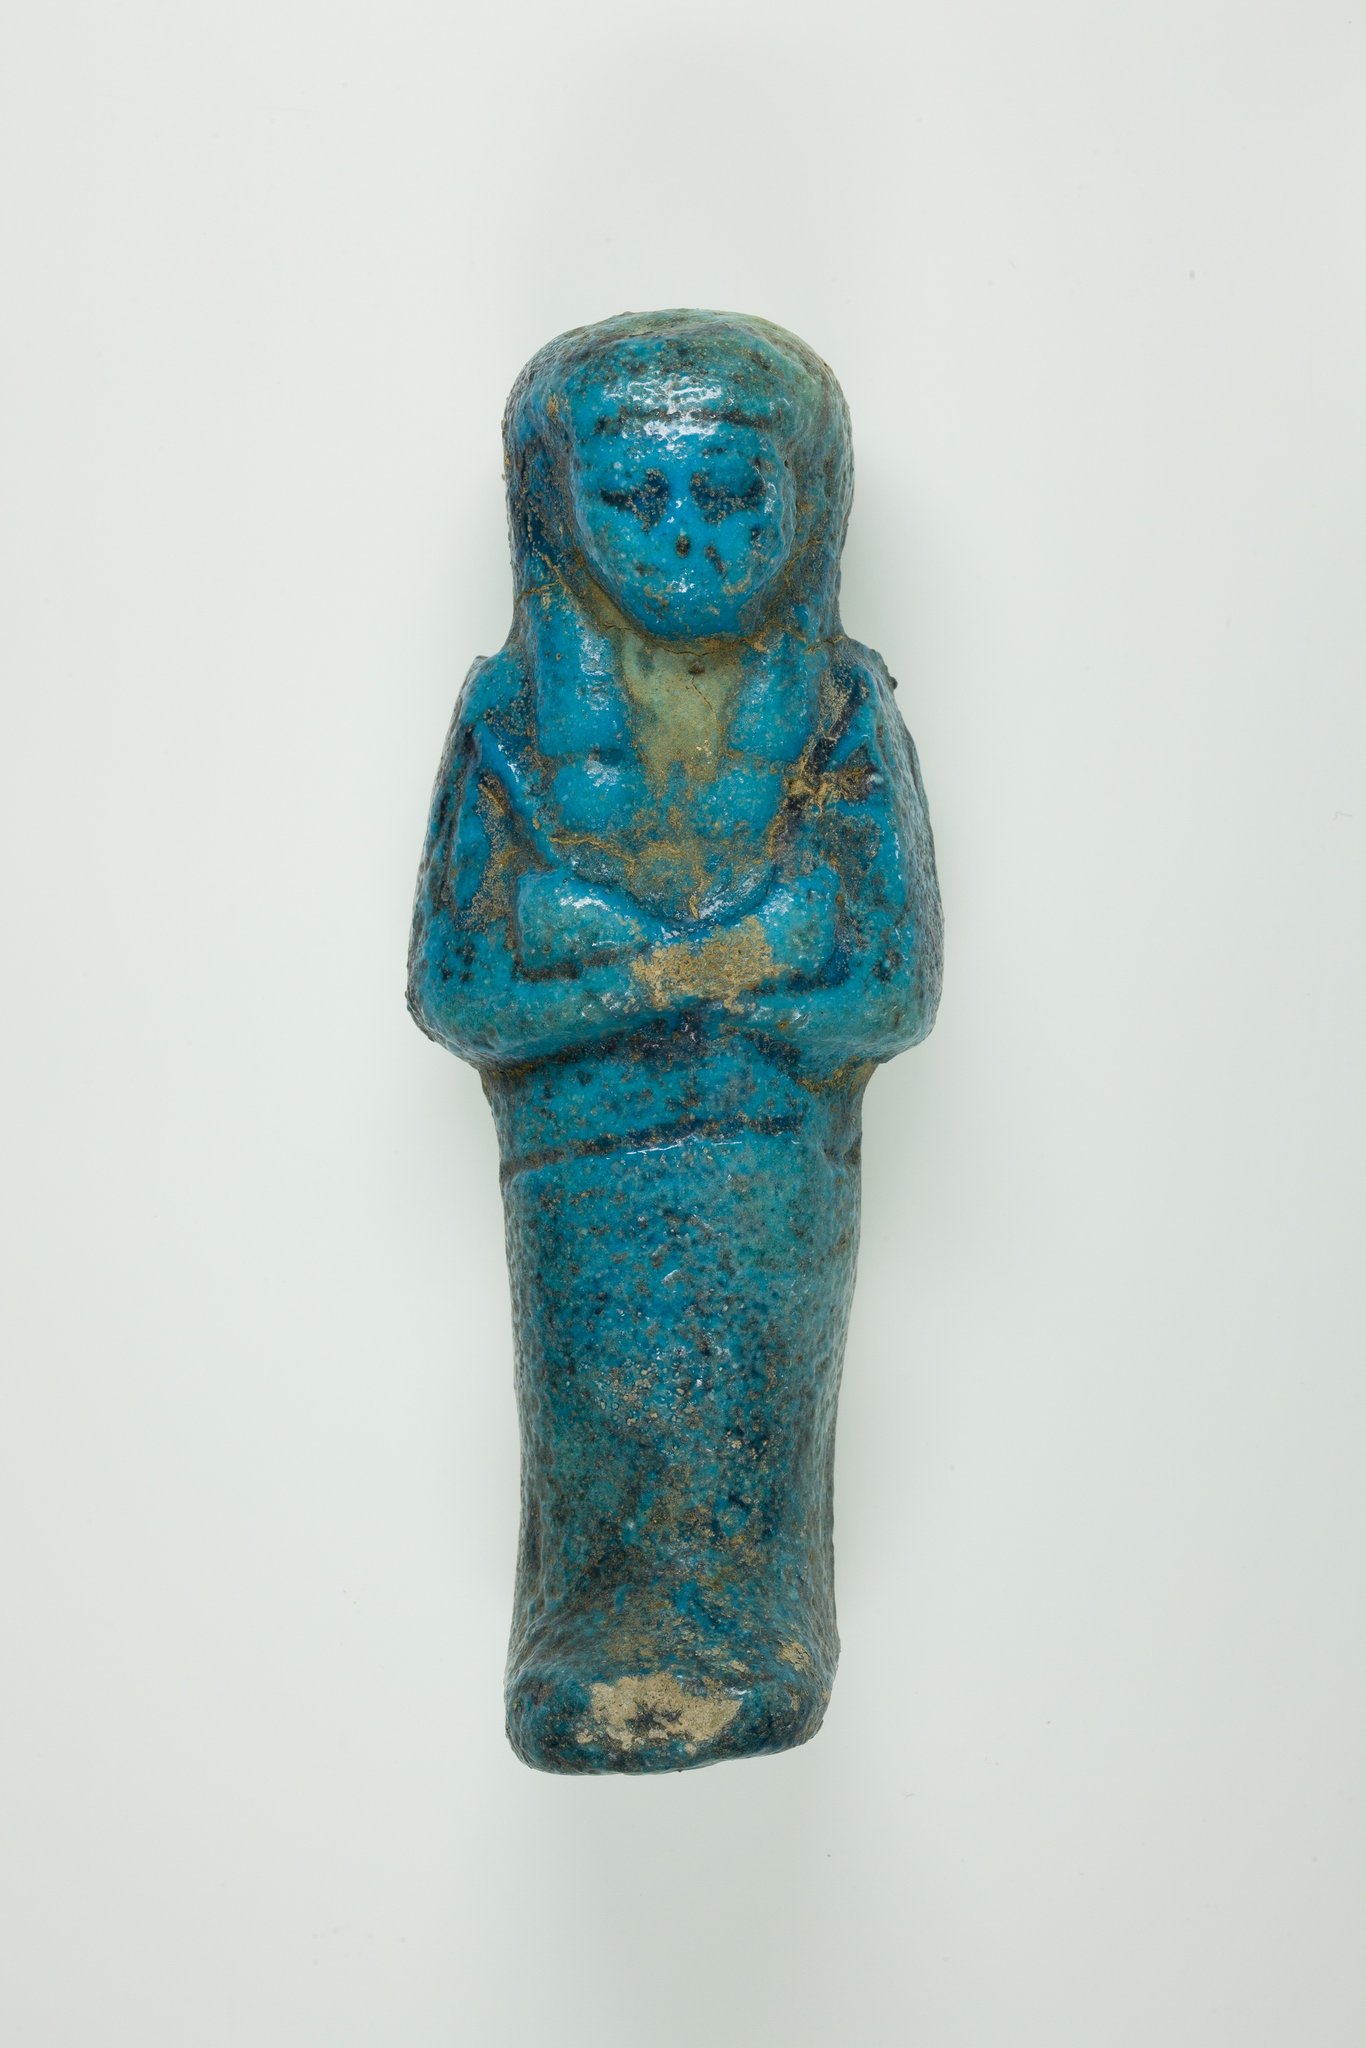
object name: worker shabti, henettawy c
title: Worker Shabti of Henettawy (C), Daughter of Isetemkheb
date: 990-970 BCE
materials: faience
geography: egypt